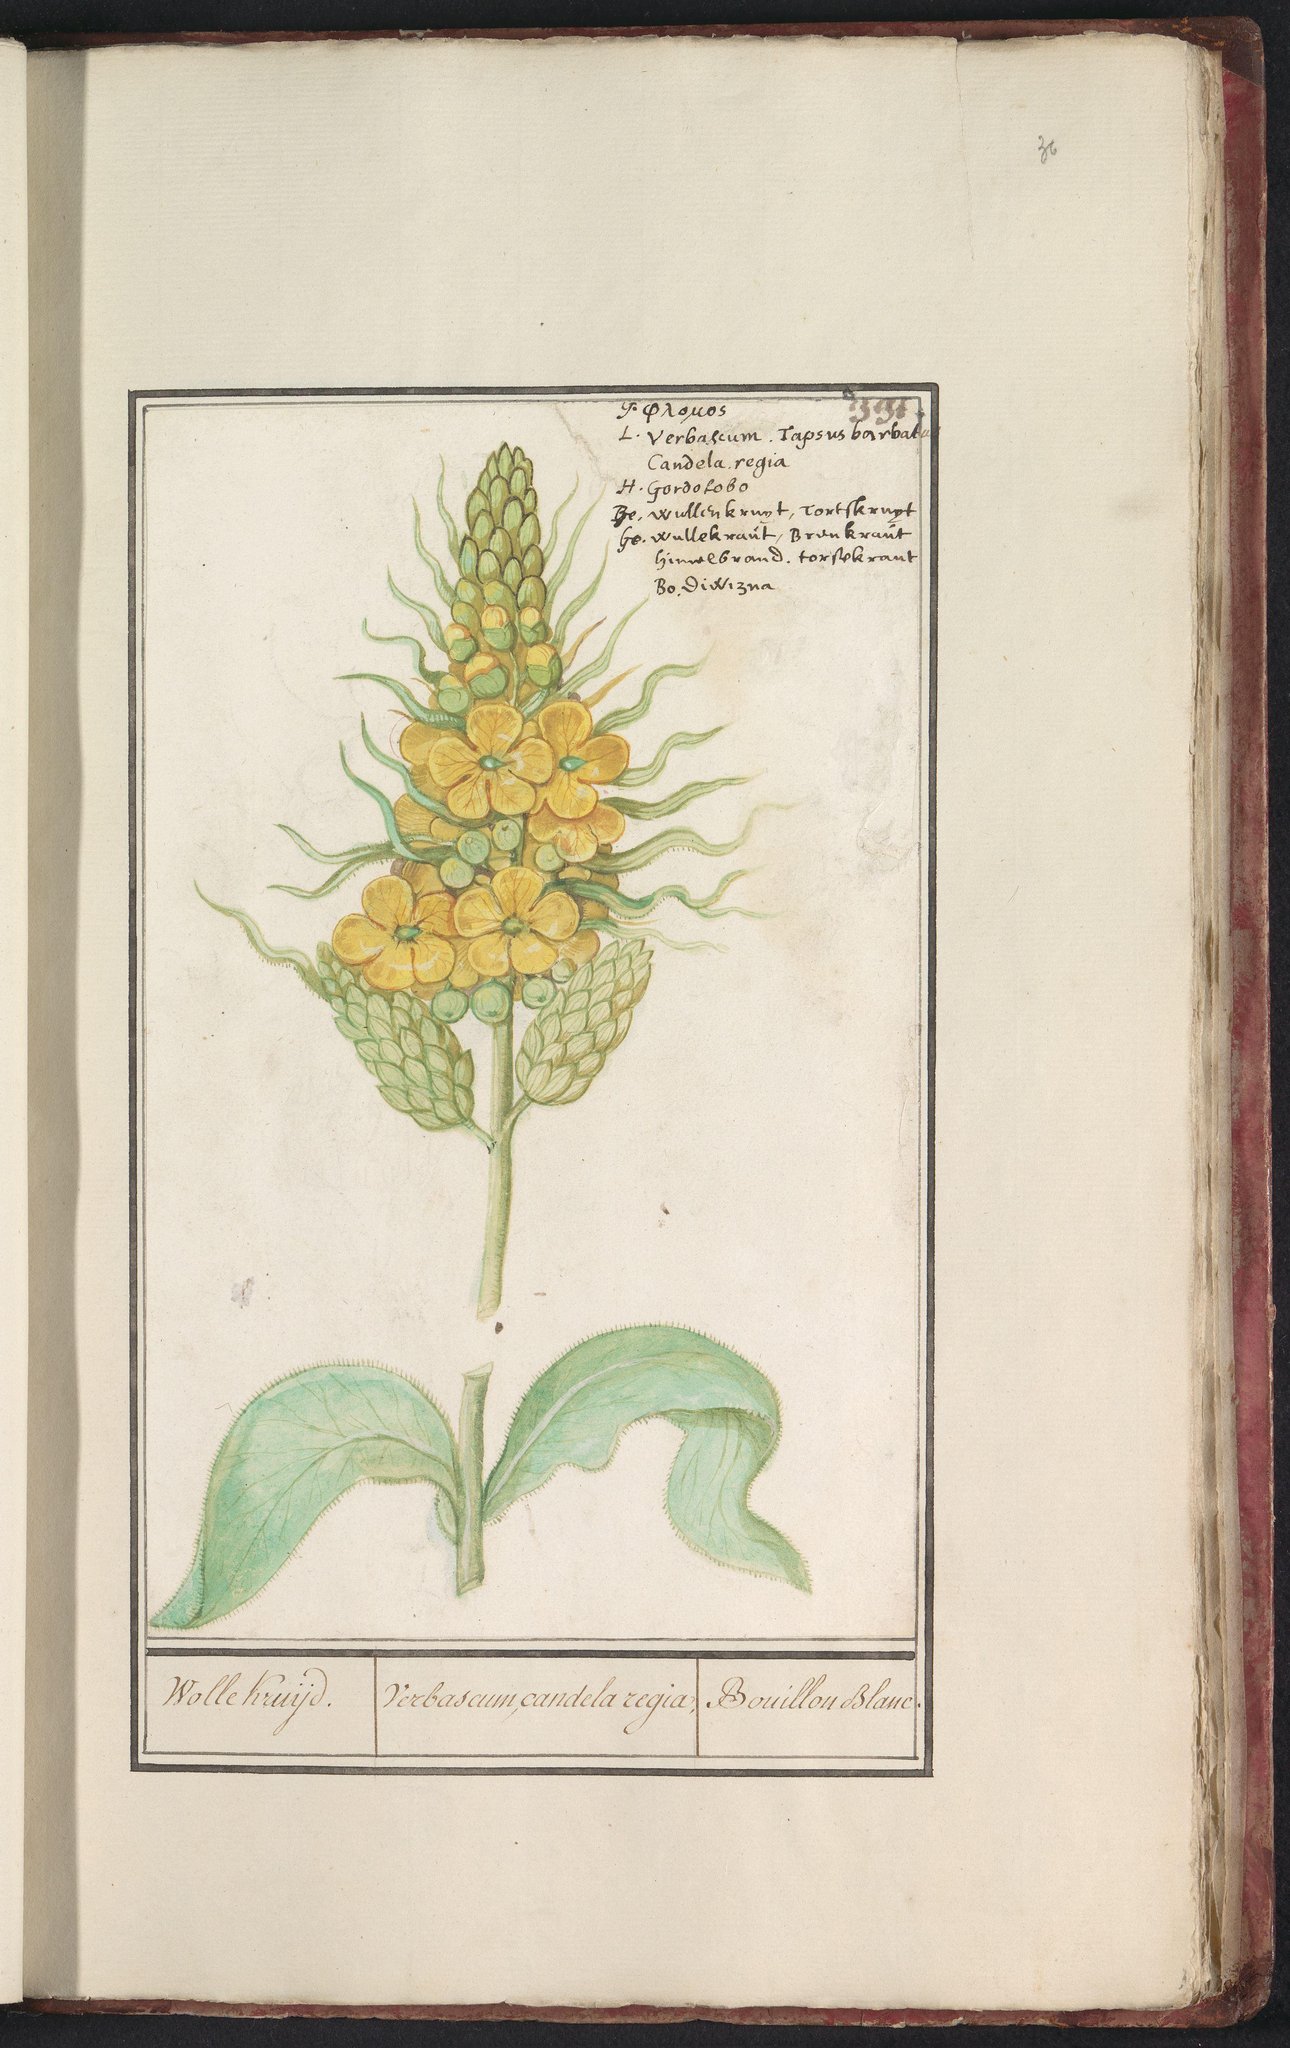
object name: drawing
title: Wolle Kruijd. / Verbascum, candela regia. / Bouillon blanc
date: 1596-1610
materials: chalk, paint, ink, paper, watercolor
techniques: brush, pen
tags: flowers: great mullein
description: Koningskaars, of wolkruid. Genummerd rechtsboven: 331. Hierbij ook de naam in zes talen. Onderdeel van het vierde album met tekeningen van bloemen en paddestoelen. Elfde van twaalf albums met tekeningen van dieren, vogels en planten bekend rond 1600, gemaakt in opdracht van keizer Rudolf II. Met toelichting in Nederlands, Latijn en Frans.